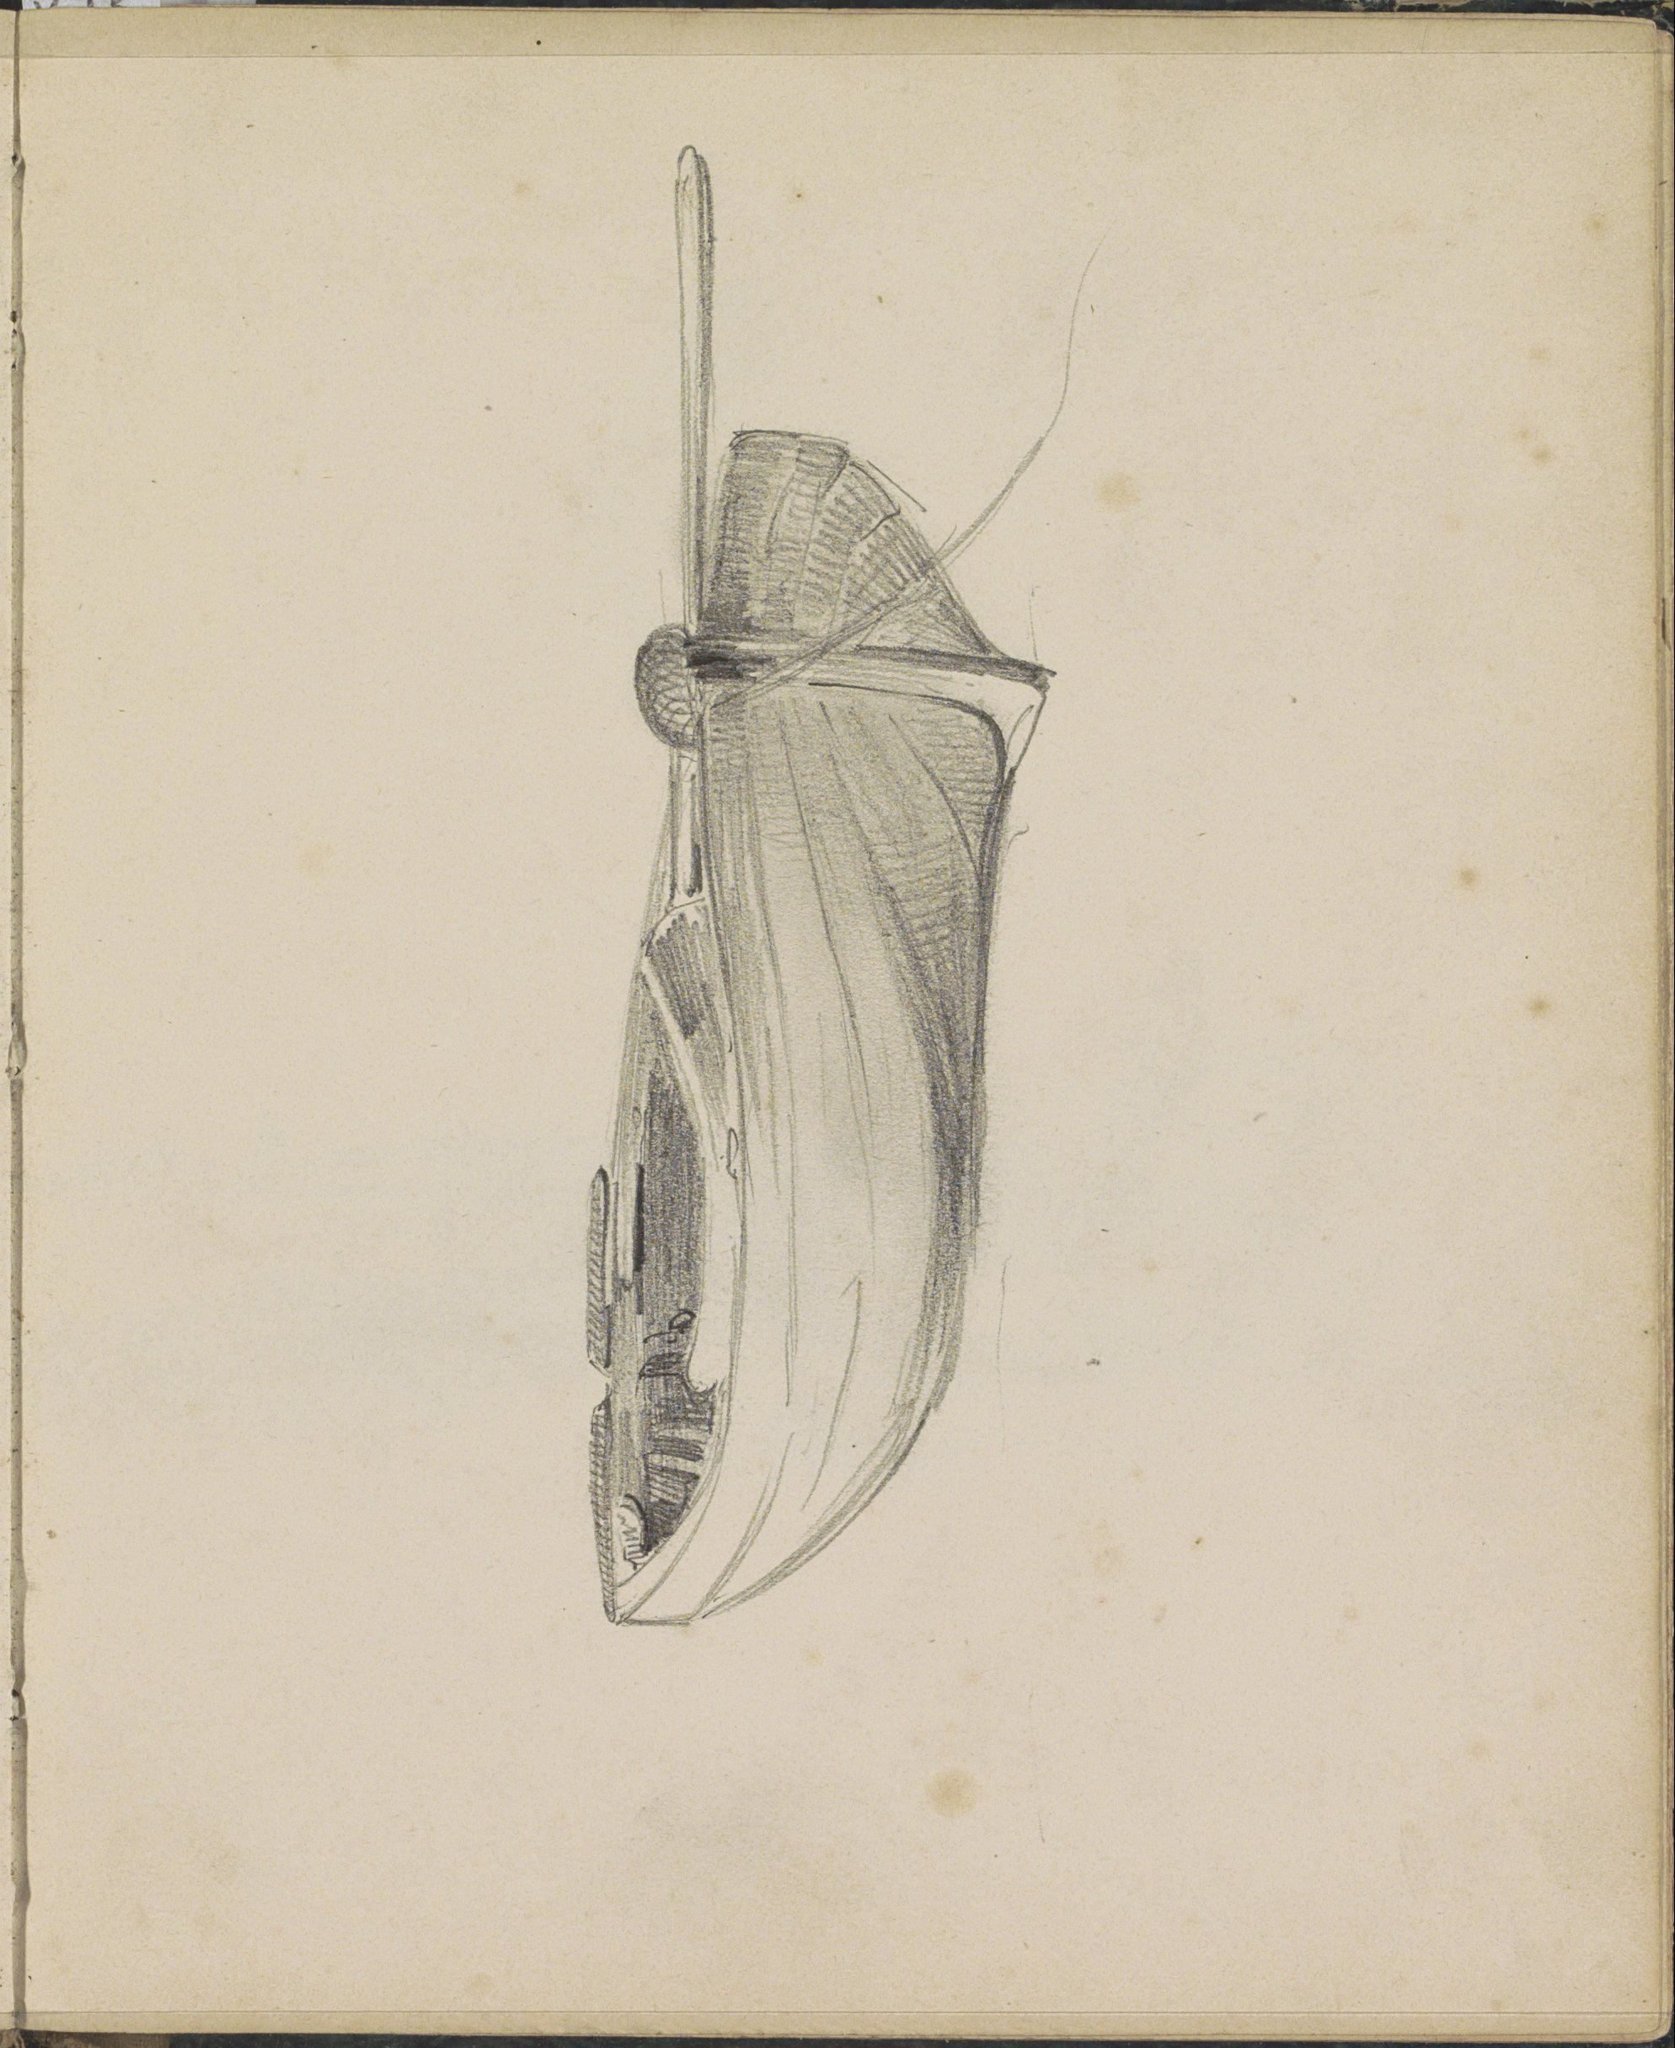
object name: sketchbook leaf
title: Roeiboot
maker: johannes tavenraat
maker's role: draughtsman, painter, print maker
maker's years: 1809-1881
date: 1841-1853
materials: paper, pencil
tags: rowing-boat, canoe, etc.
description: Blad 44 recto uit een schetsboek met 87 bladen.